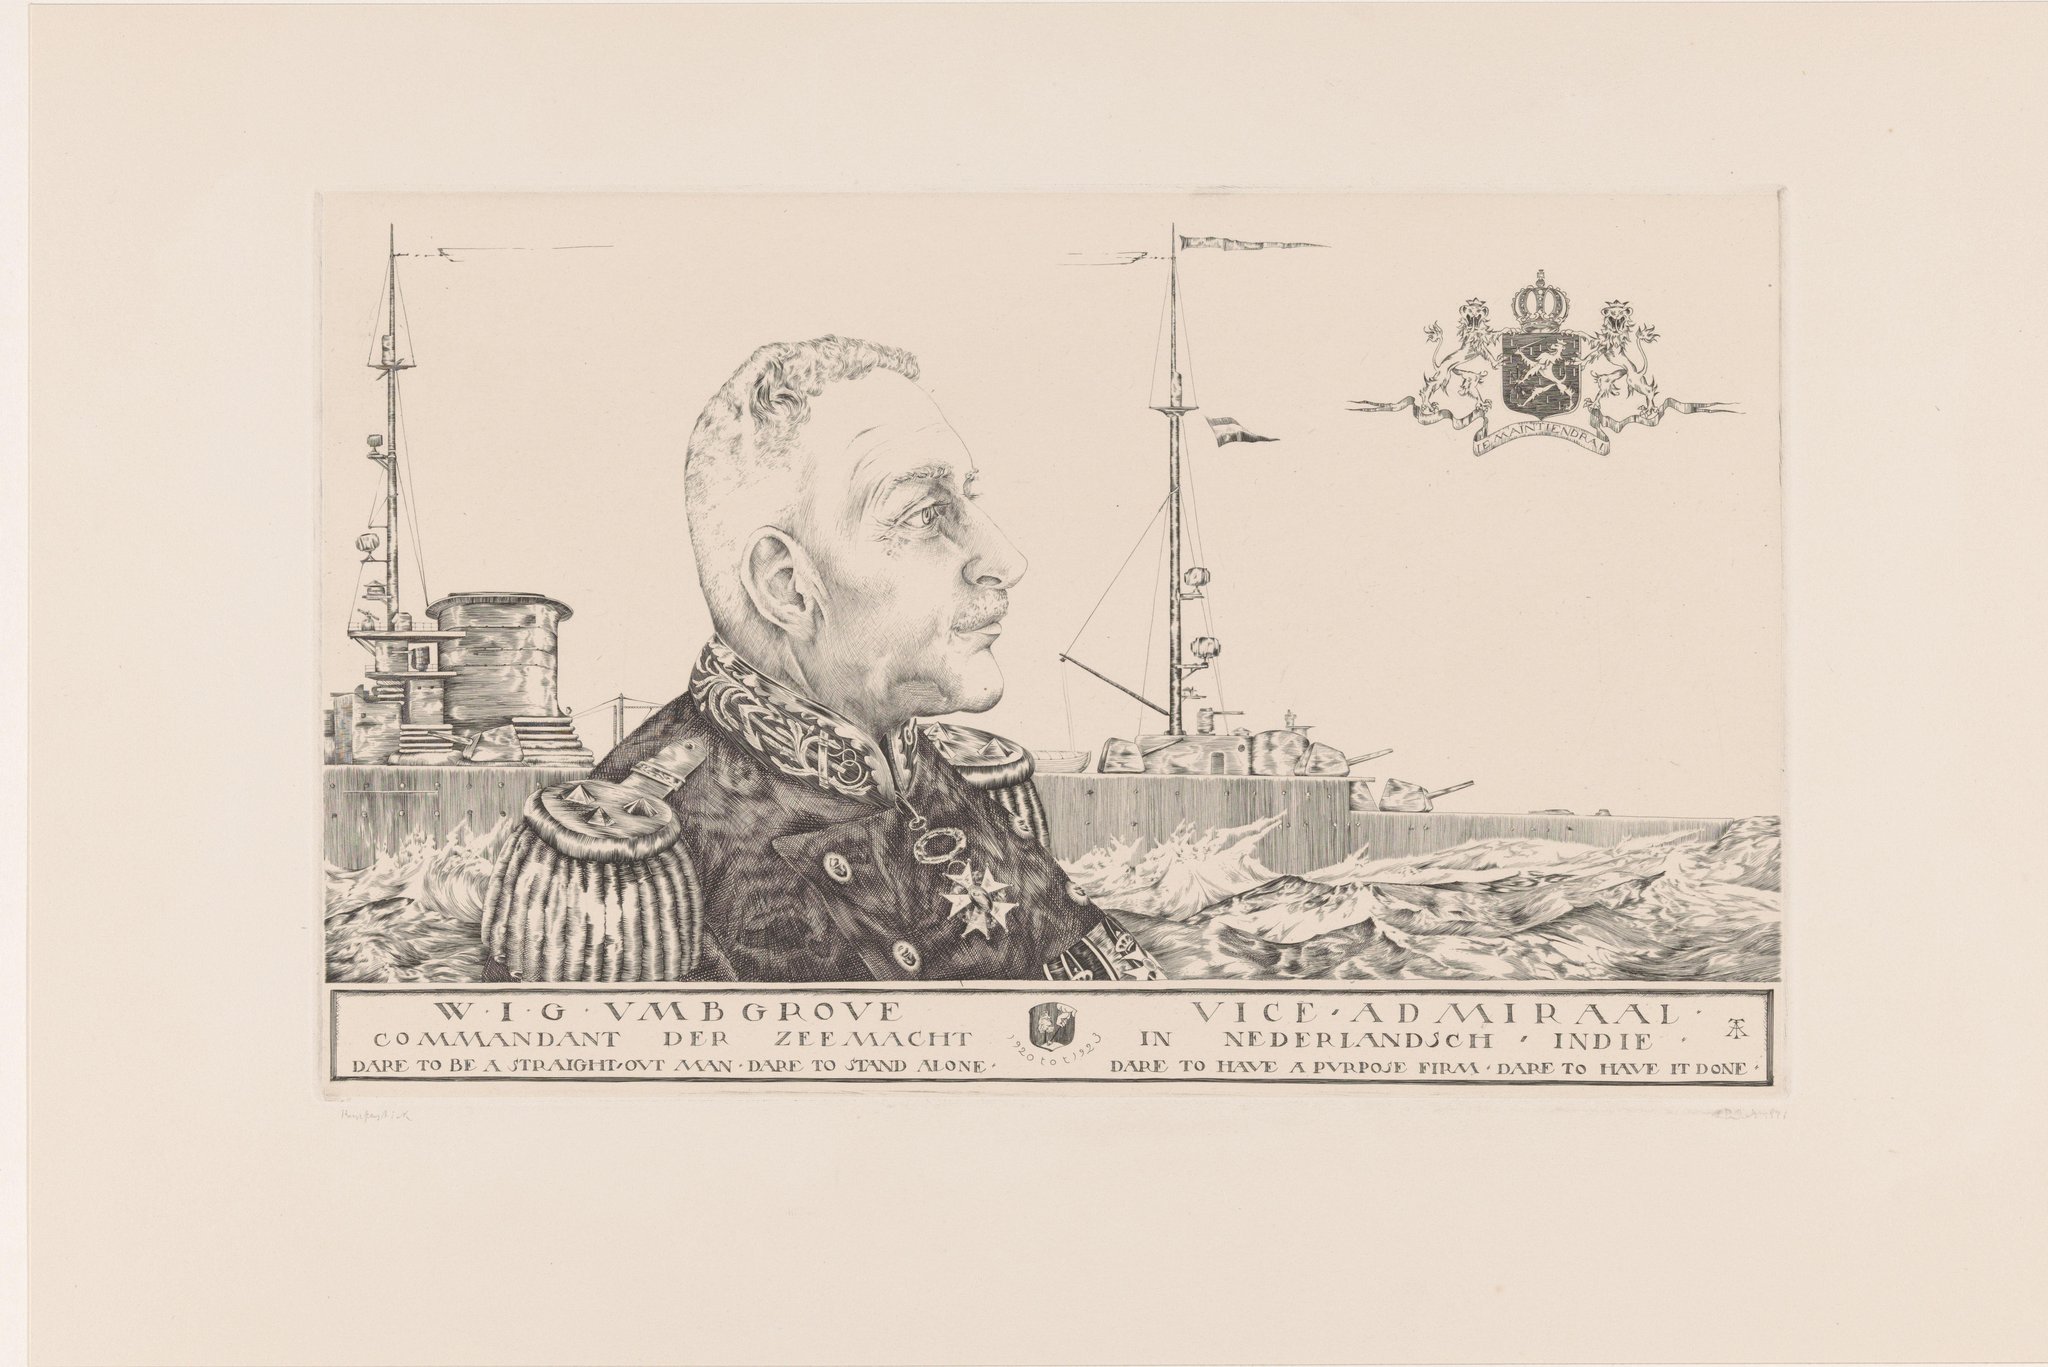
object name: print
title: Portret van Wilhelm Johannes Gerrit Umbgrove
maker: monogrammist at (20e eeuw)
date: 1926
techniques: printmaking, engraving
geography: netherlands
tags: historical persons, commander-in-chief, admiral, dutch east indies, the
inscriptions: inscription: ‘Dare to be a straight-out man . Dare to stand alone . Dare to have a purpose firm . Dare to have it done.’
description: Portret van vice-admiraal W.J.G. Umbgrove. Borststuk in groot uniform met de Militaire Willemsorde, naar rechts en profil. Achter hem een marineschip op zee. Rechtsboven het wapen van Nederland; onder opschrift.